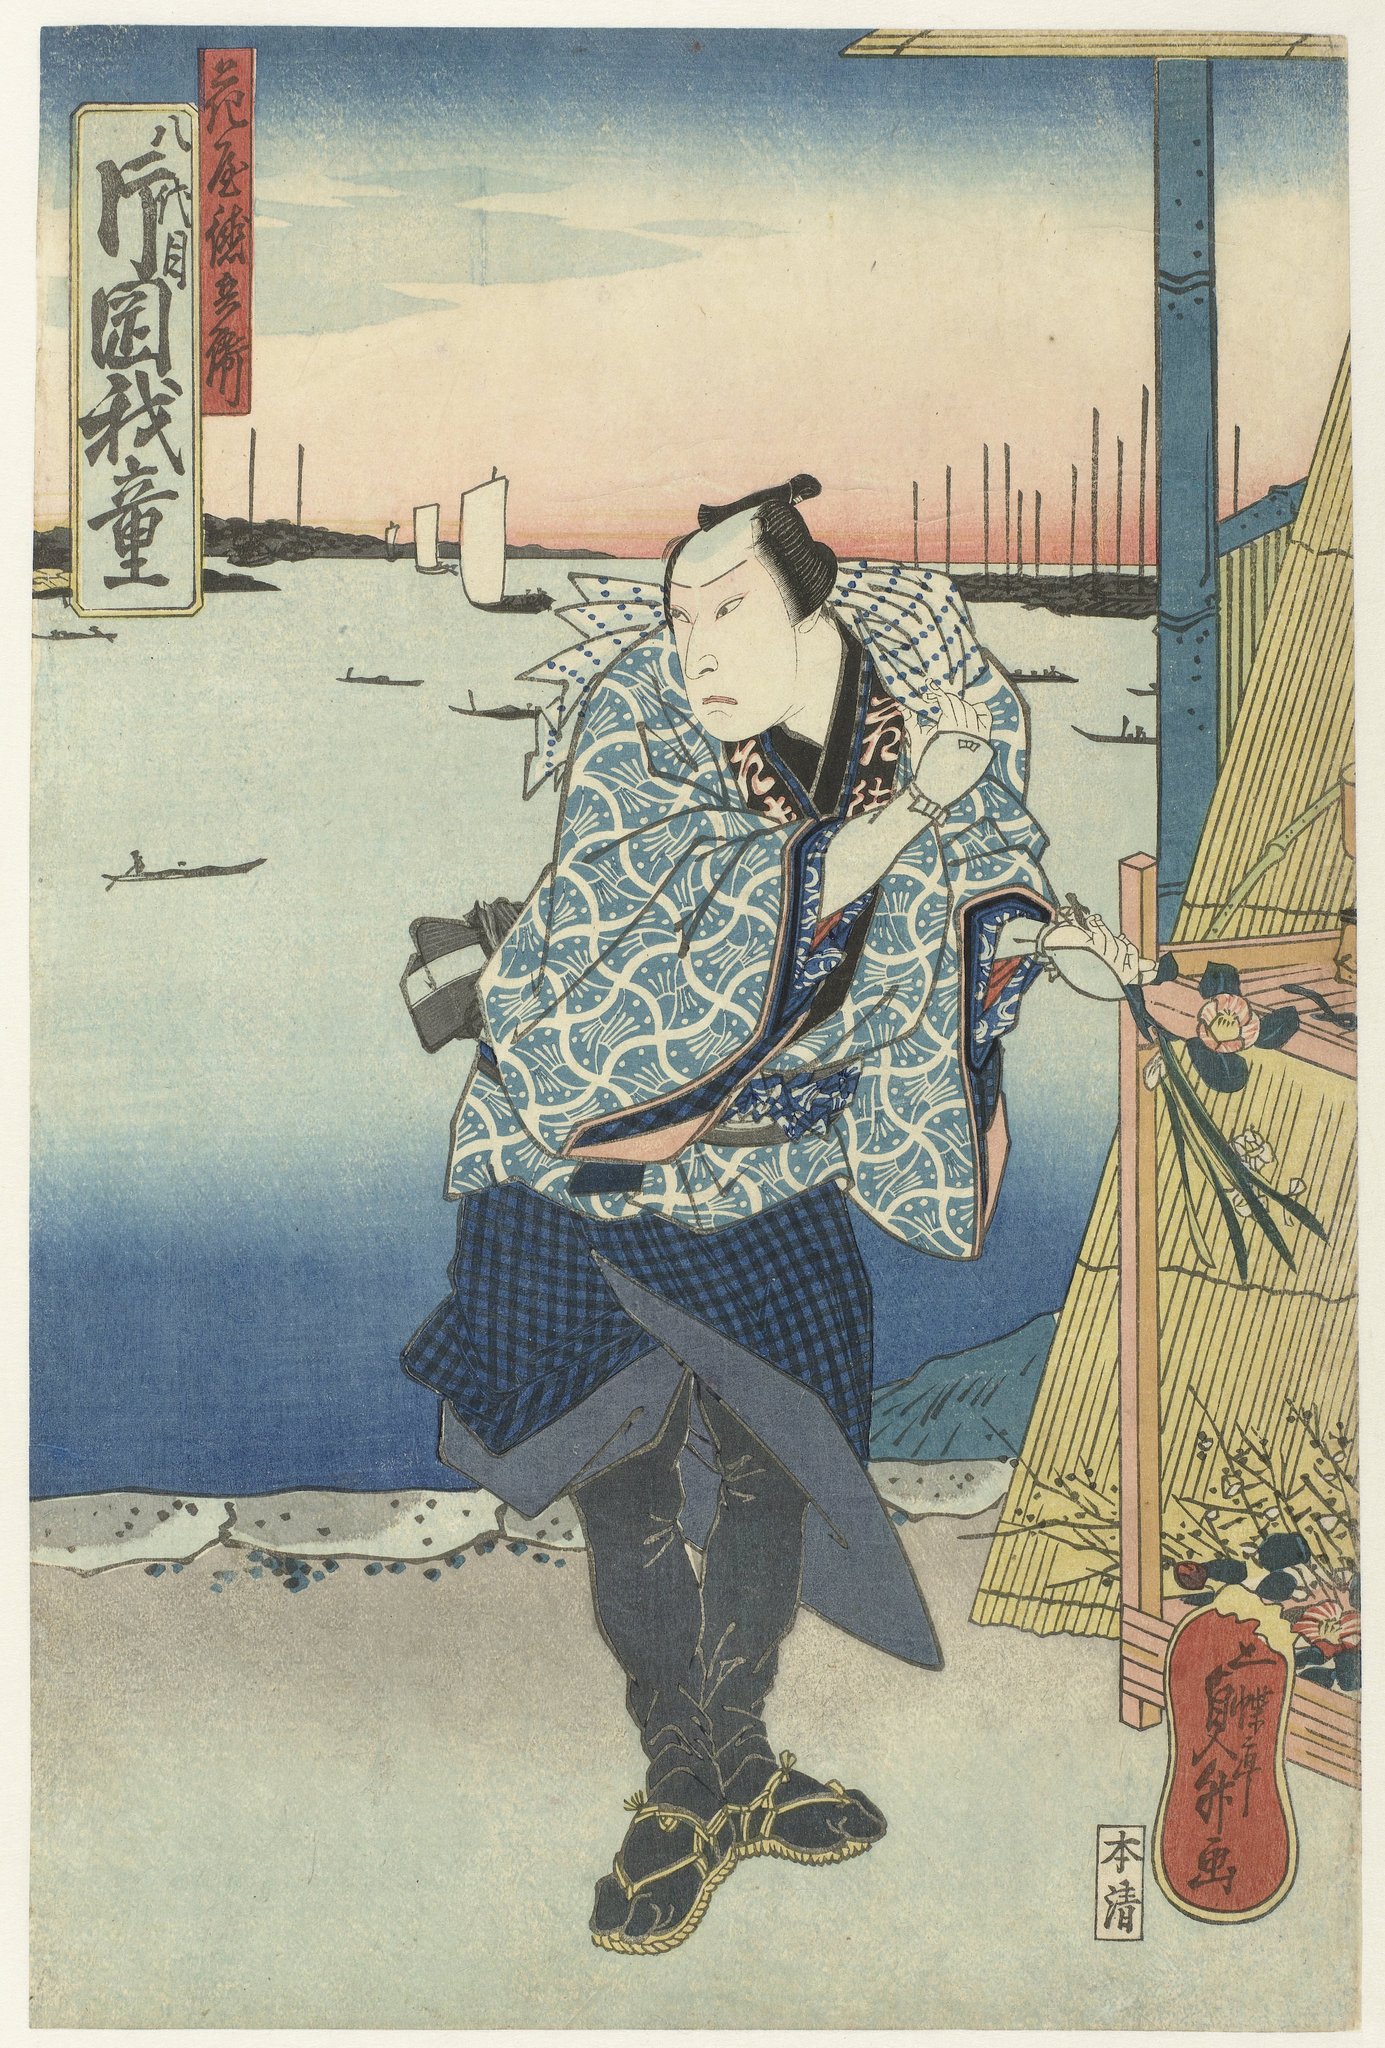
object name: print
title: Bloemist in de haven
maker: utagawa sadamasu (ii)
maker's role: print maker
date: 1801-1840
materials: paper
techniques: woodcut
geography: osaka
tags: harbour, flowers, portrait of actor, actress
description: Toneelspeler Kataoka Gadô II in de rol van bloemist Tokubei, in het stuk ‘Keisei setsugekka’, opgevoerd in het Naka Theater in de eerste maand van 1840.